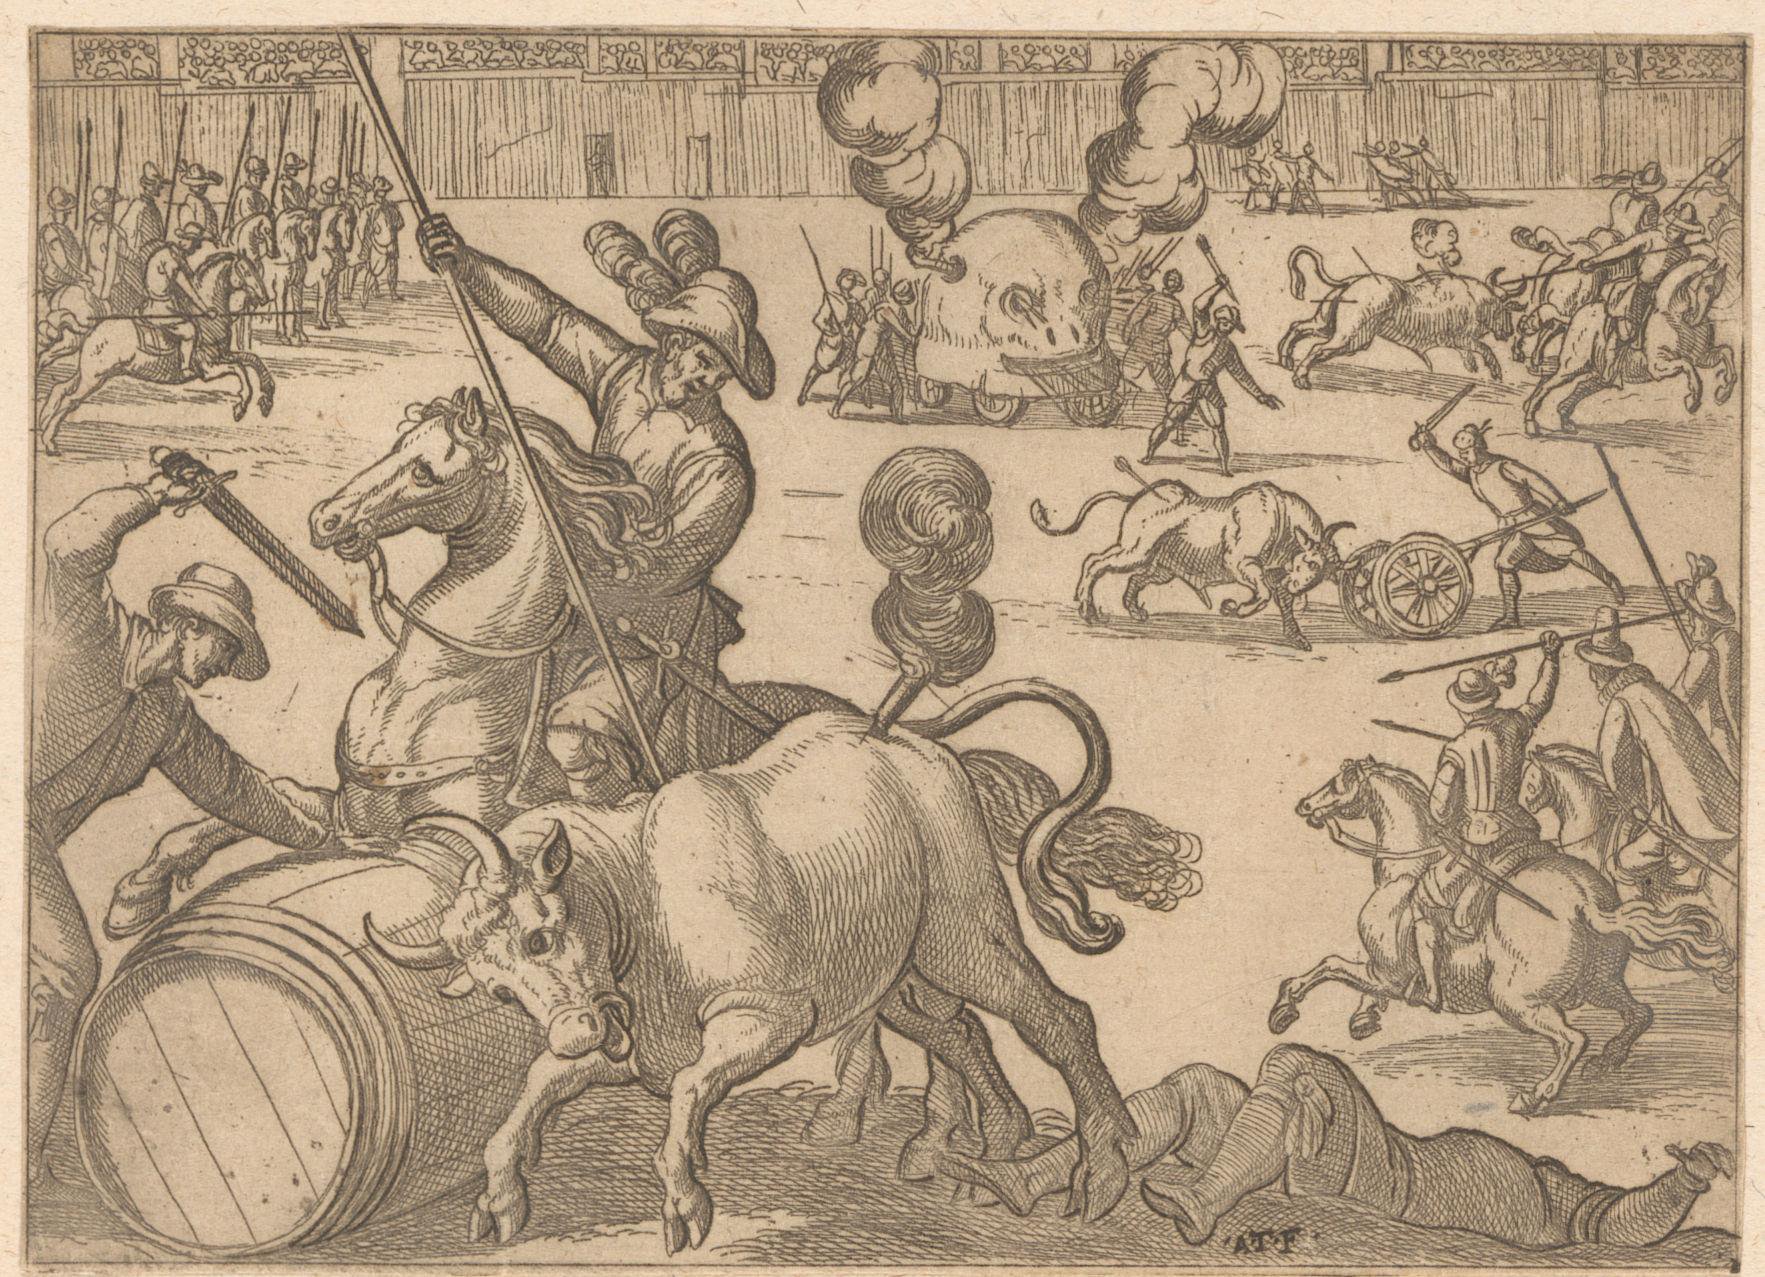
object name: print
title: Jacht op stieren in een arena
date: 1598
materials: paper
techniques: etching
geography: vatican city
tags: bull, hunter, hunters hunting (n.b.: in 1988-1990 this notation denoted the concept of 43c11421 'hunters resting during the hunt'), hunt ~ mammals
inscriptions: collector's mark: Lugt 2165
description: Deze prent maakt deel uit van een reeks van 45 jachtscènes (+ titelprent en opdracht).